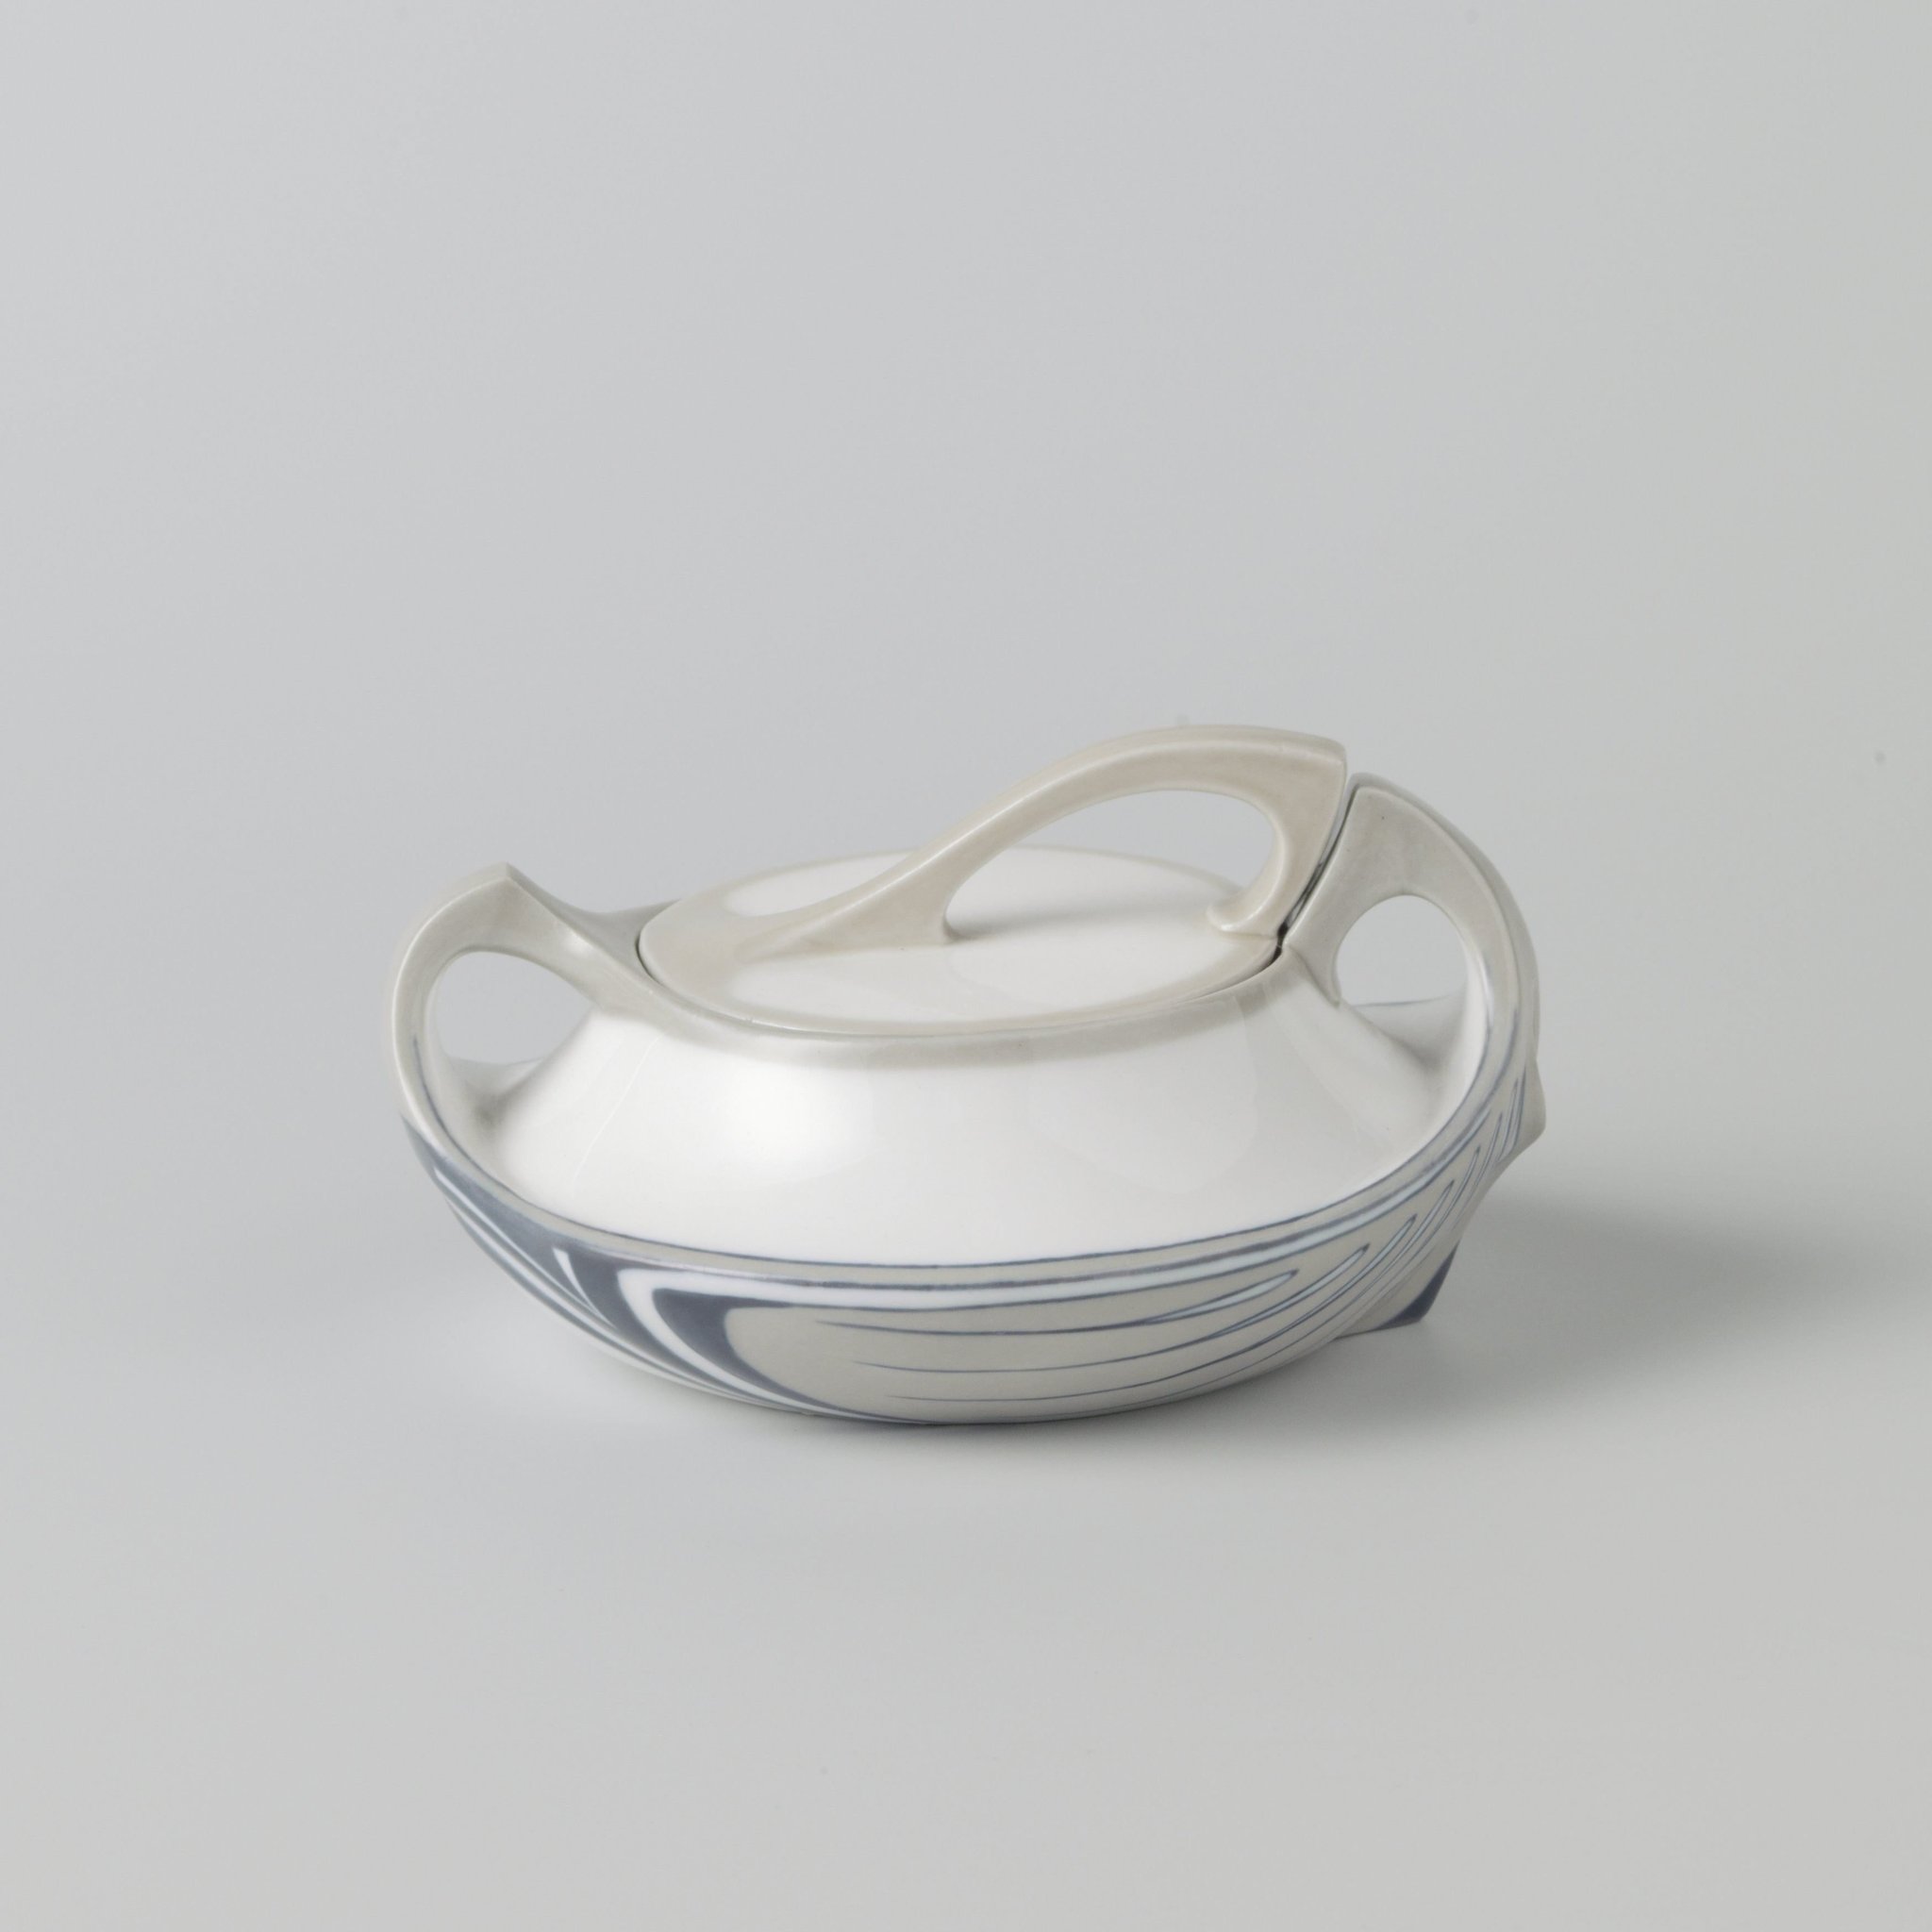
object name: sugar box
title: Suikerpot uit het koffie- en theeservies 'Saxonia'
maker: otto eduard voigt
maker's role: keramiekontwerper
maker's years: 1870-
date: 1904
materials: porcelain, chemical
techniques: painted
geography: meissen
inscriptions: mark: ‘57’, model number: ‘U 125’, factory mark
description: Suikerpot van porselein, beschilderd in blauw en grijs. De pot heeft een deksel. De pot hoort bij het koffie- en theeservies Saxonia. De suikerpot is gemerkt.